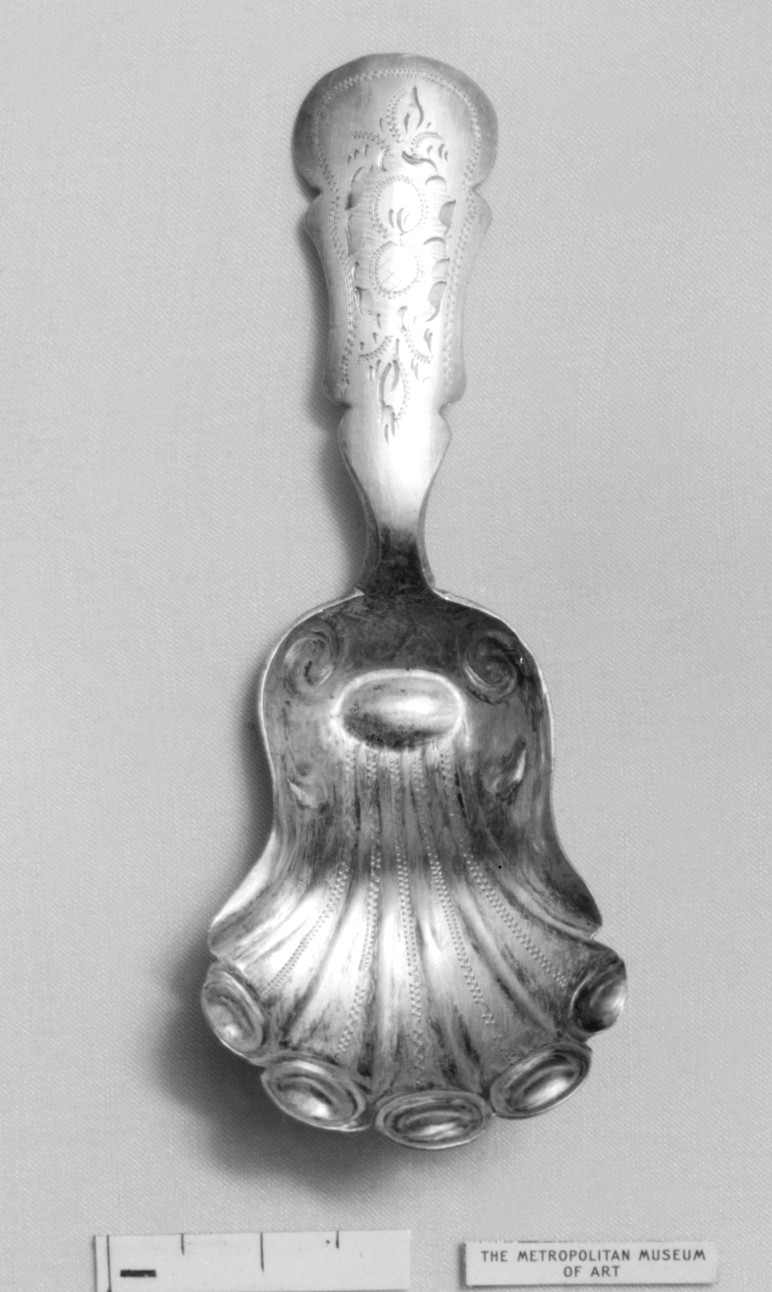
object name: caddy spoon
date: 1801-1833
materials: silver